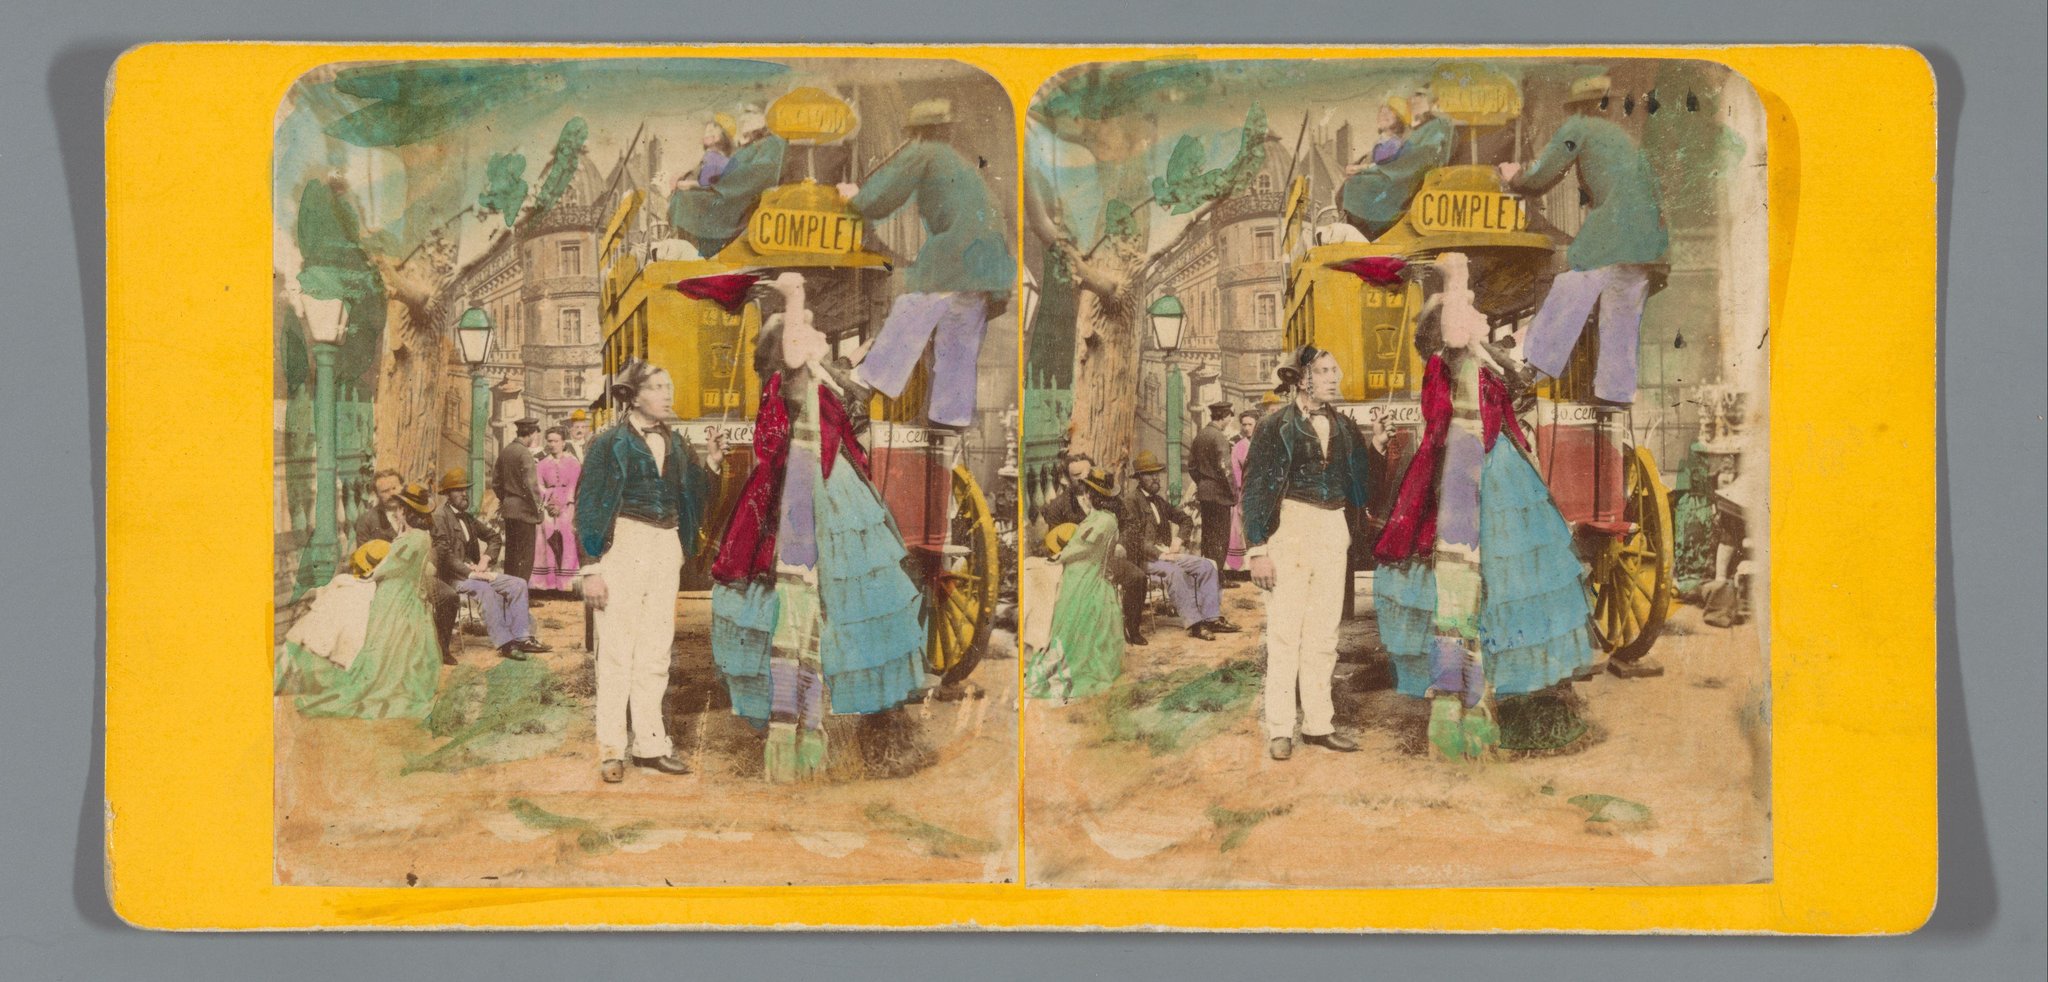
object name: stereograph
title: Vrouw in een hoepelrok zit een man achterna die op een koets klimt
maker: Anonymous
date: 1861-1890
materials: cardboard, paper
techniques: albumen print, hand coloring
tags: adult woman, adult man